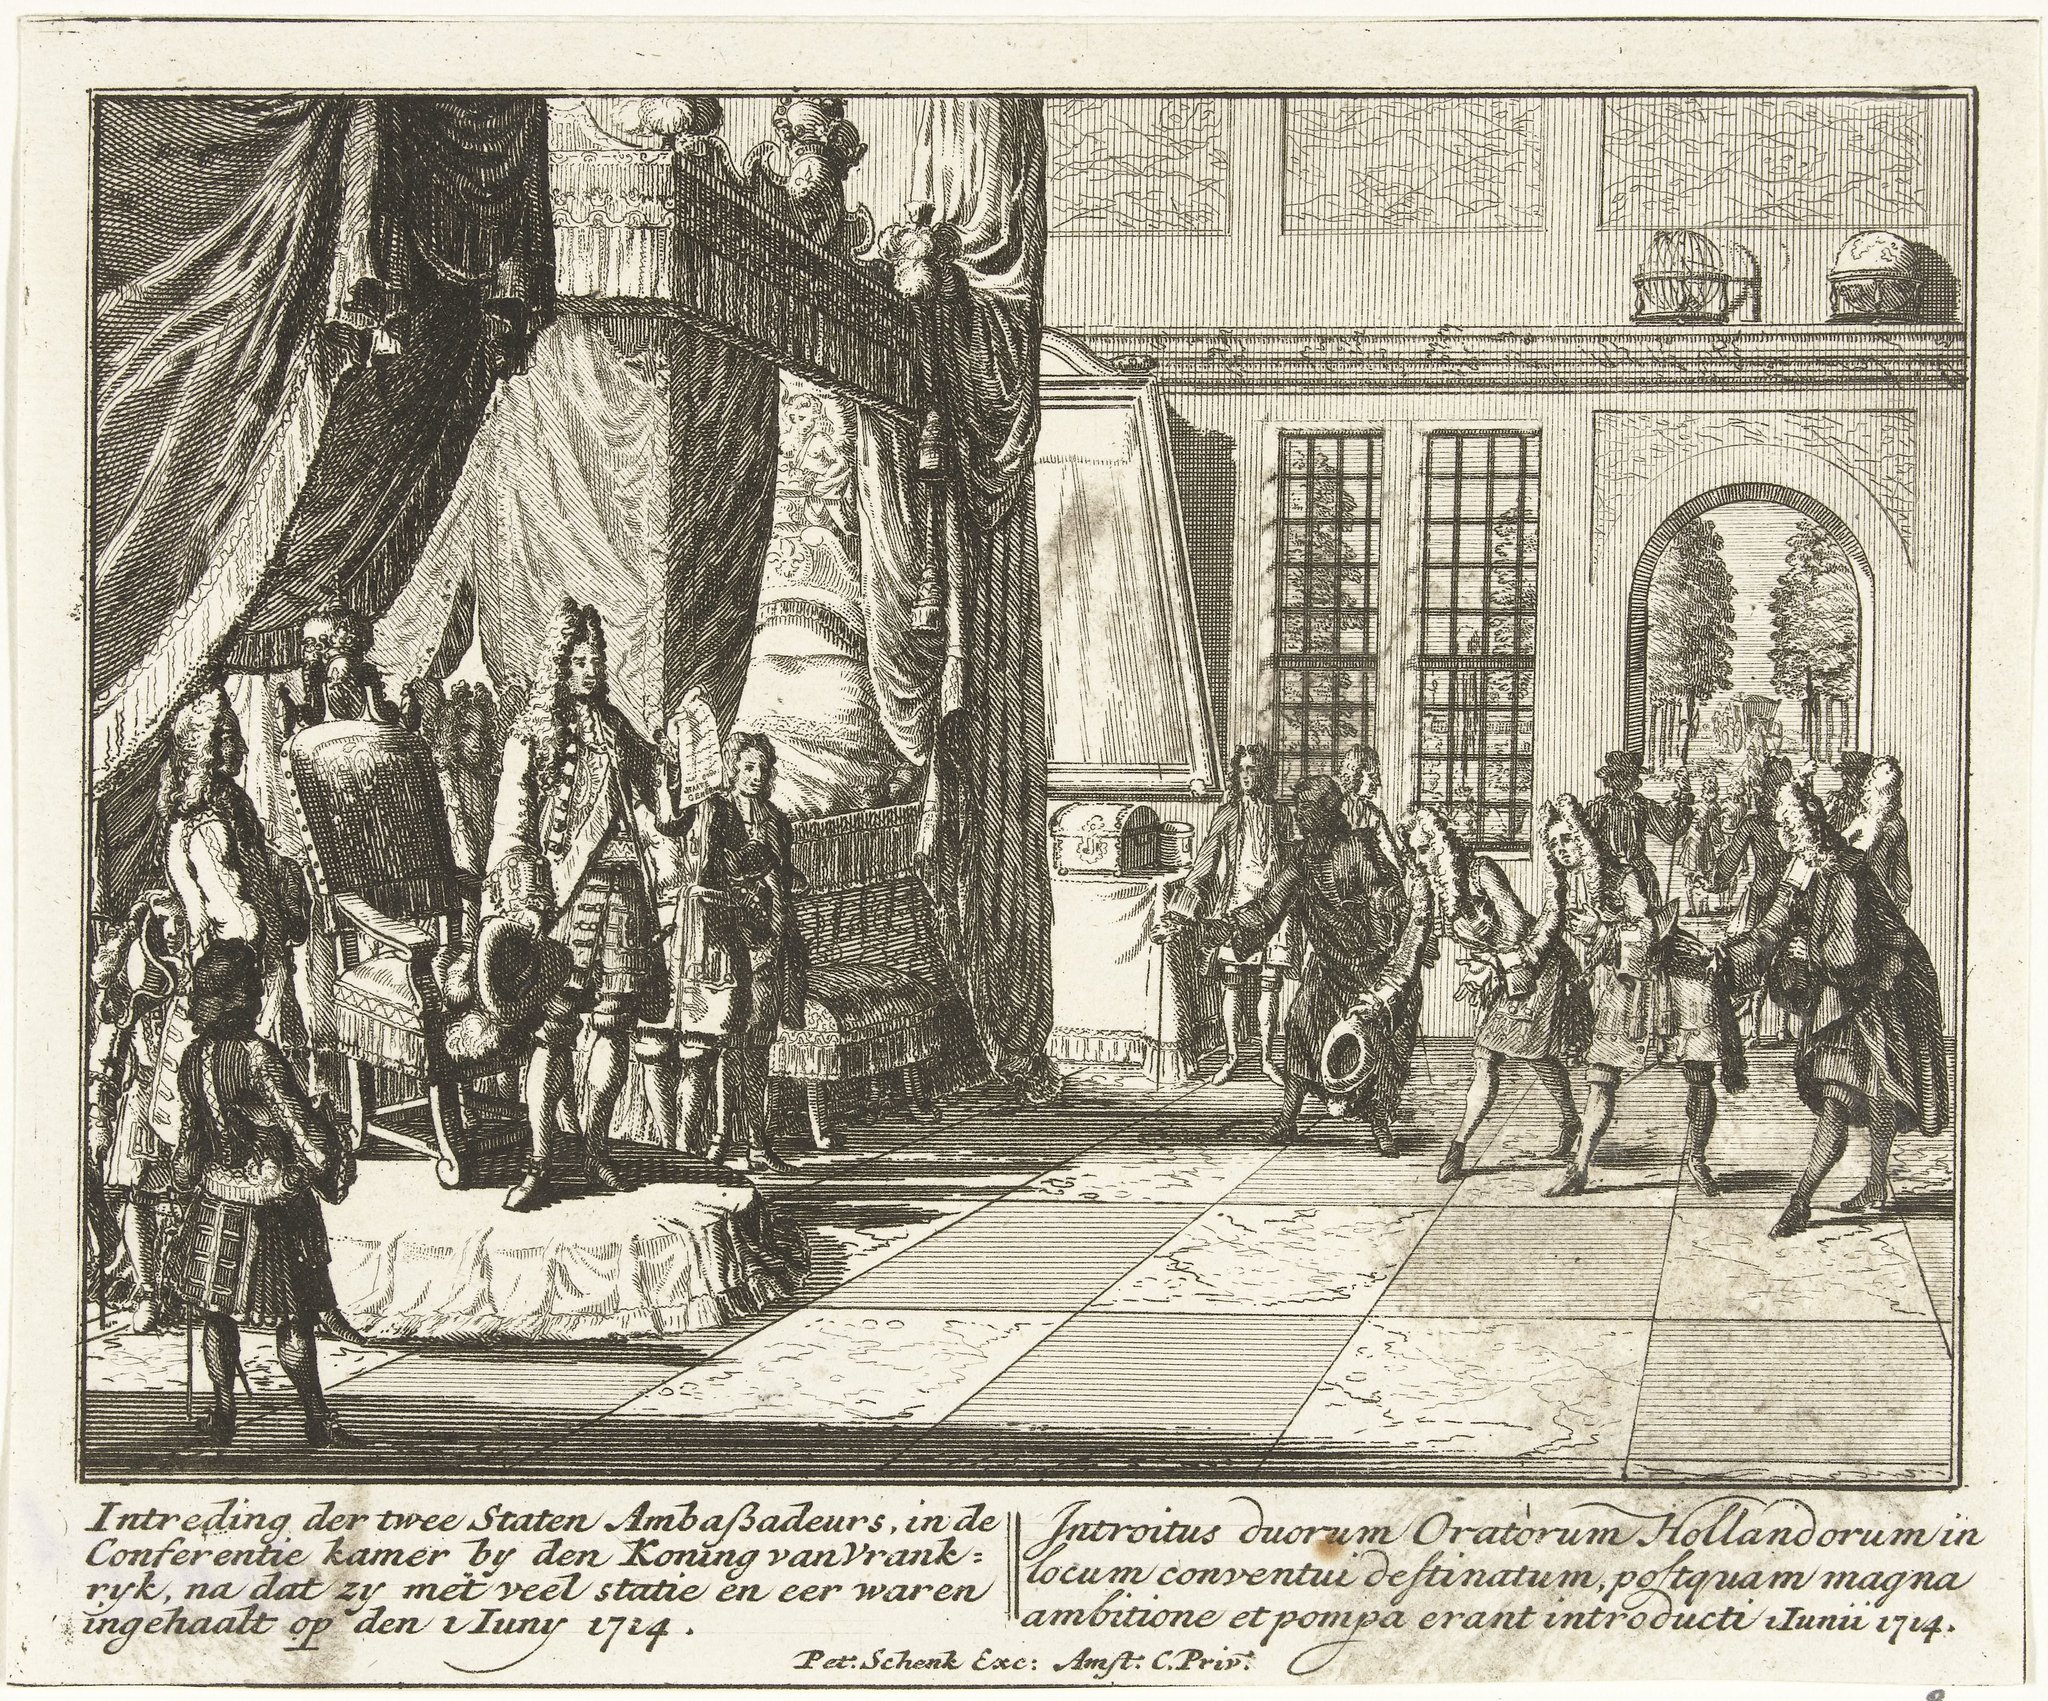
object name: print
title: Intreding der twee Staten Ambassadeurs, in de Conferentie kamer by den Koning van Vrankryk, na dat zy met veel statie en eer waren ingehaalt op den 1 Iuny 1714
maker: pieter schenk (i)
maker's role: print maker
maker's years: 1660-1711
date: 1714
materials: paper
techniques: etching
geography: amsterdam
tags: lodewijk xiv (koning van frankrijk), audition; ruler giving audience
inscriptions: collector's mark: Lugt 2228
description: Audiëntie van de twee nieuwe Nederlandse ambassadeurs bij de Franse koning Lodewijk XIV, 1 juni 1714. Fragment van een grote plaat met negen voorstellingen van gebeurtenissen uit het jaar 1714 van de Spaanse Successieoorlog.